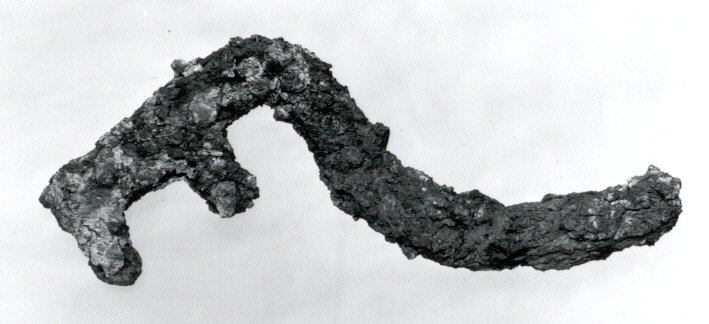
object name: key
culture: sasanian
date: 201-700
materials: iron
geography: iran